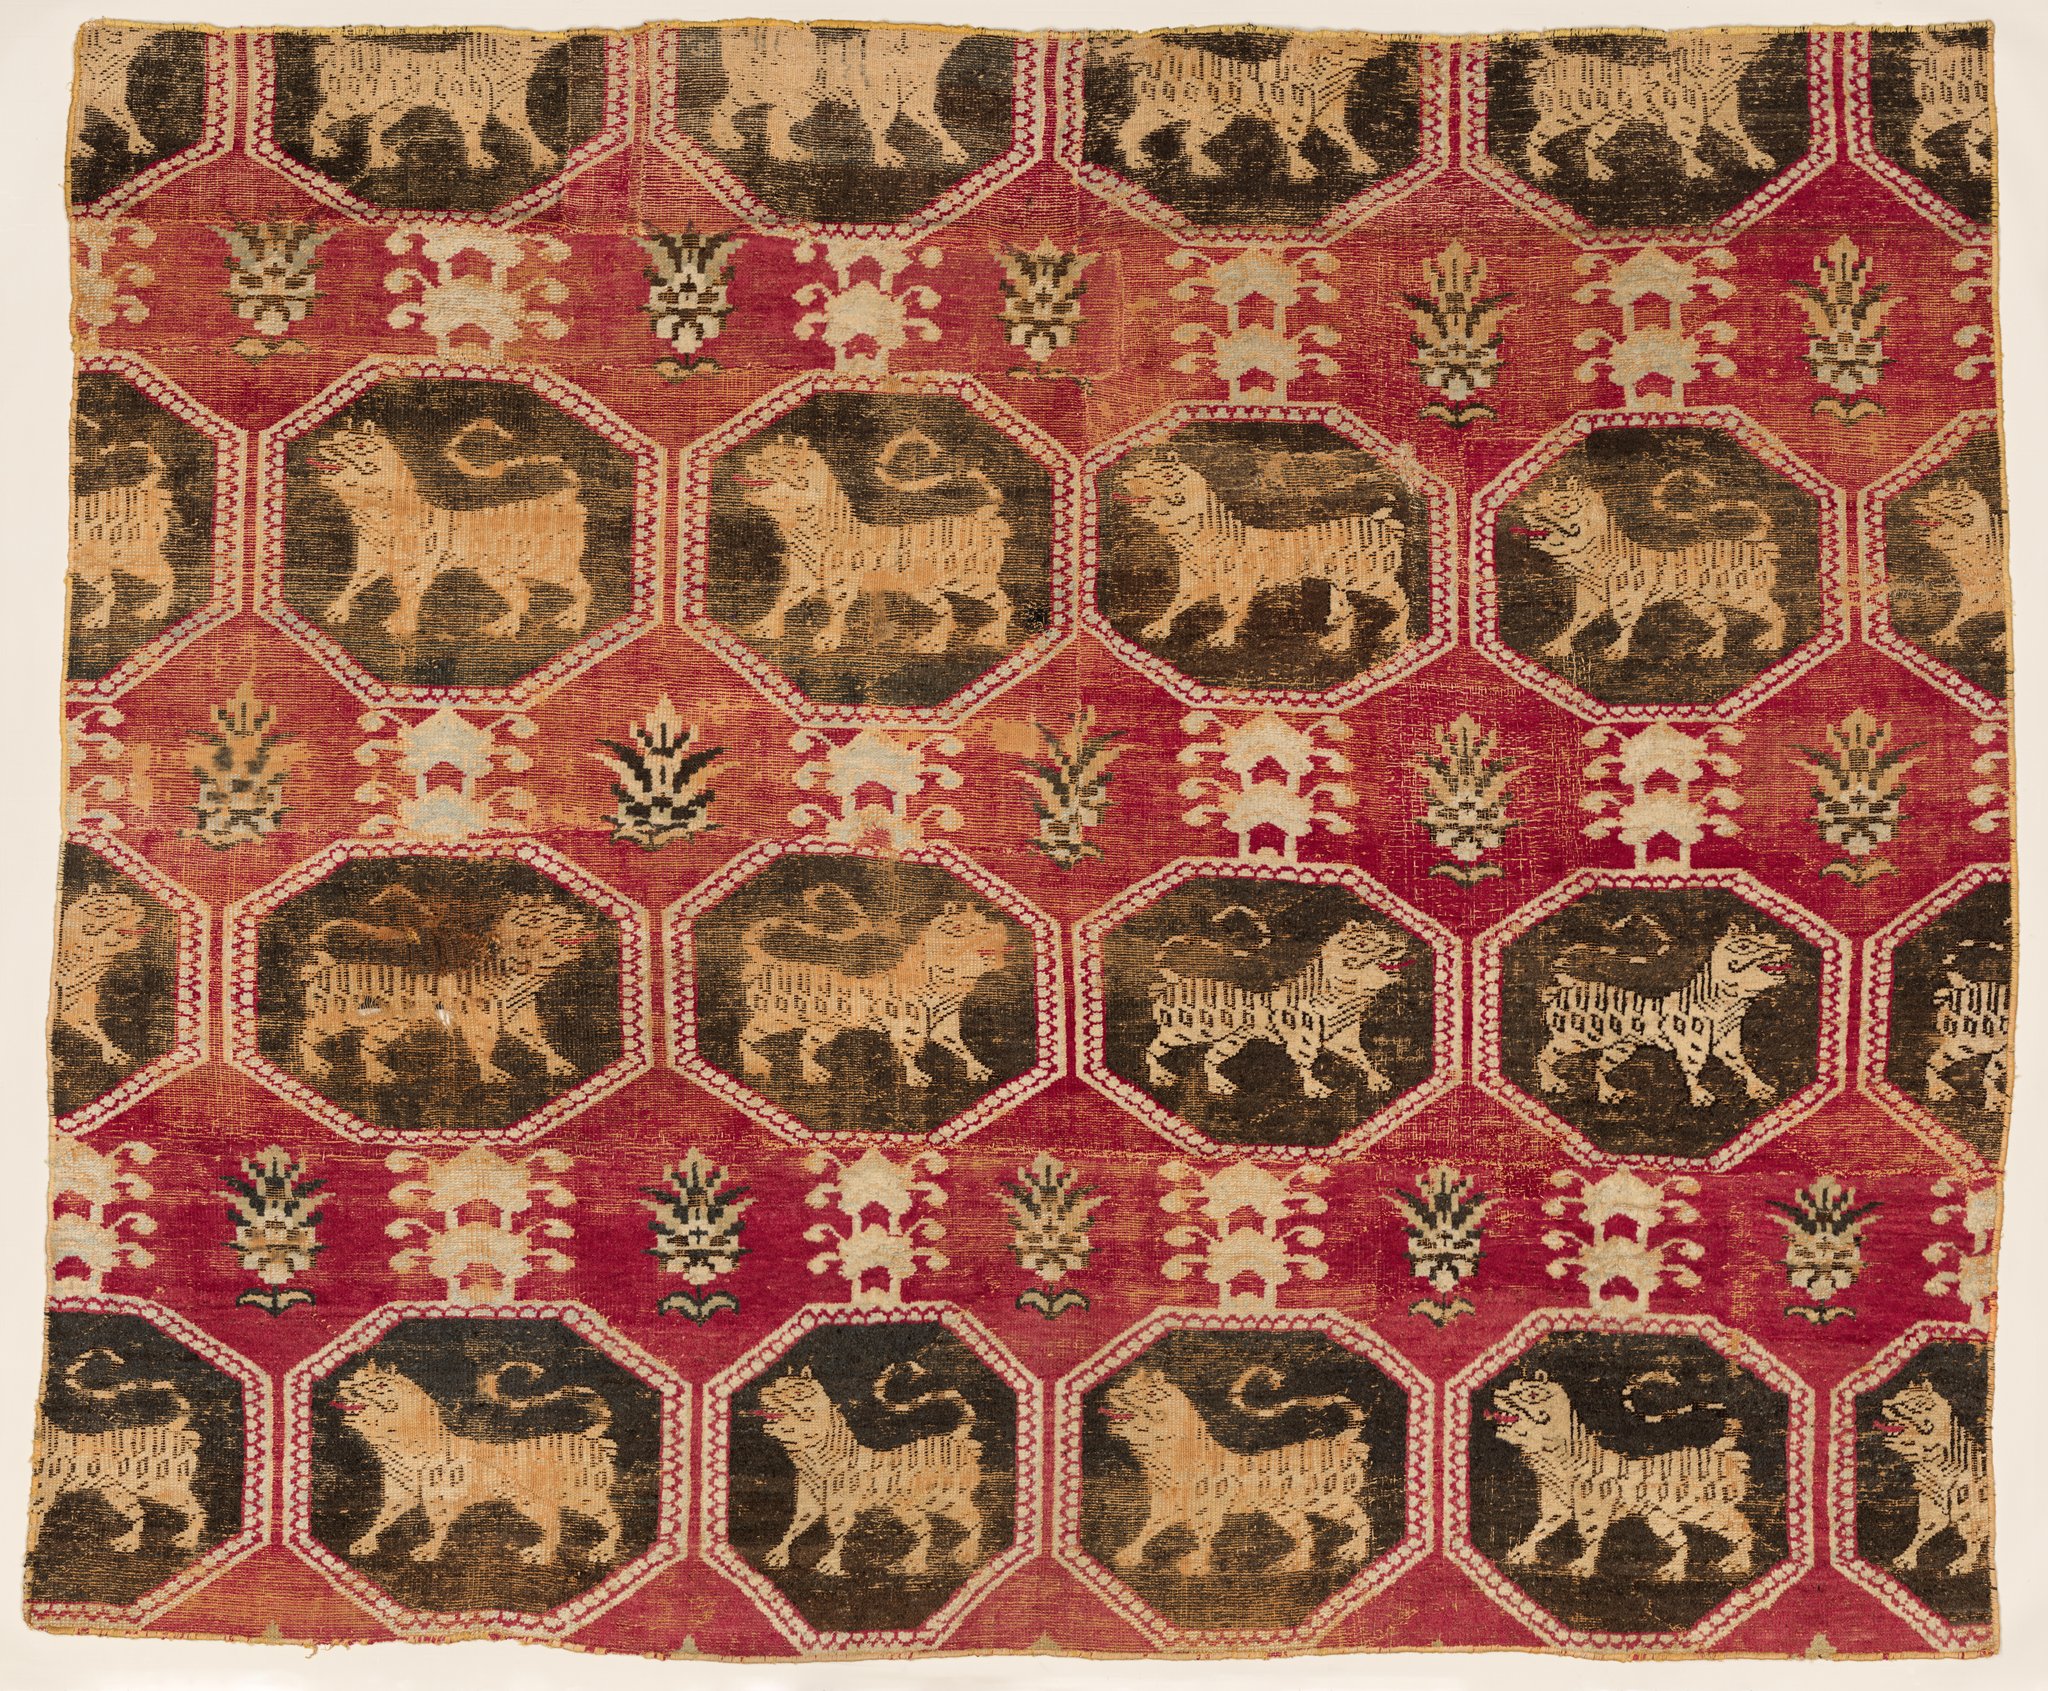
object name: carpet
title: Portuguese Goa Carpet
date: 1650-1700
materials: cotton, wool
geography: india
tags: tigers